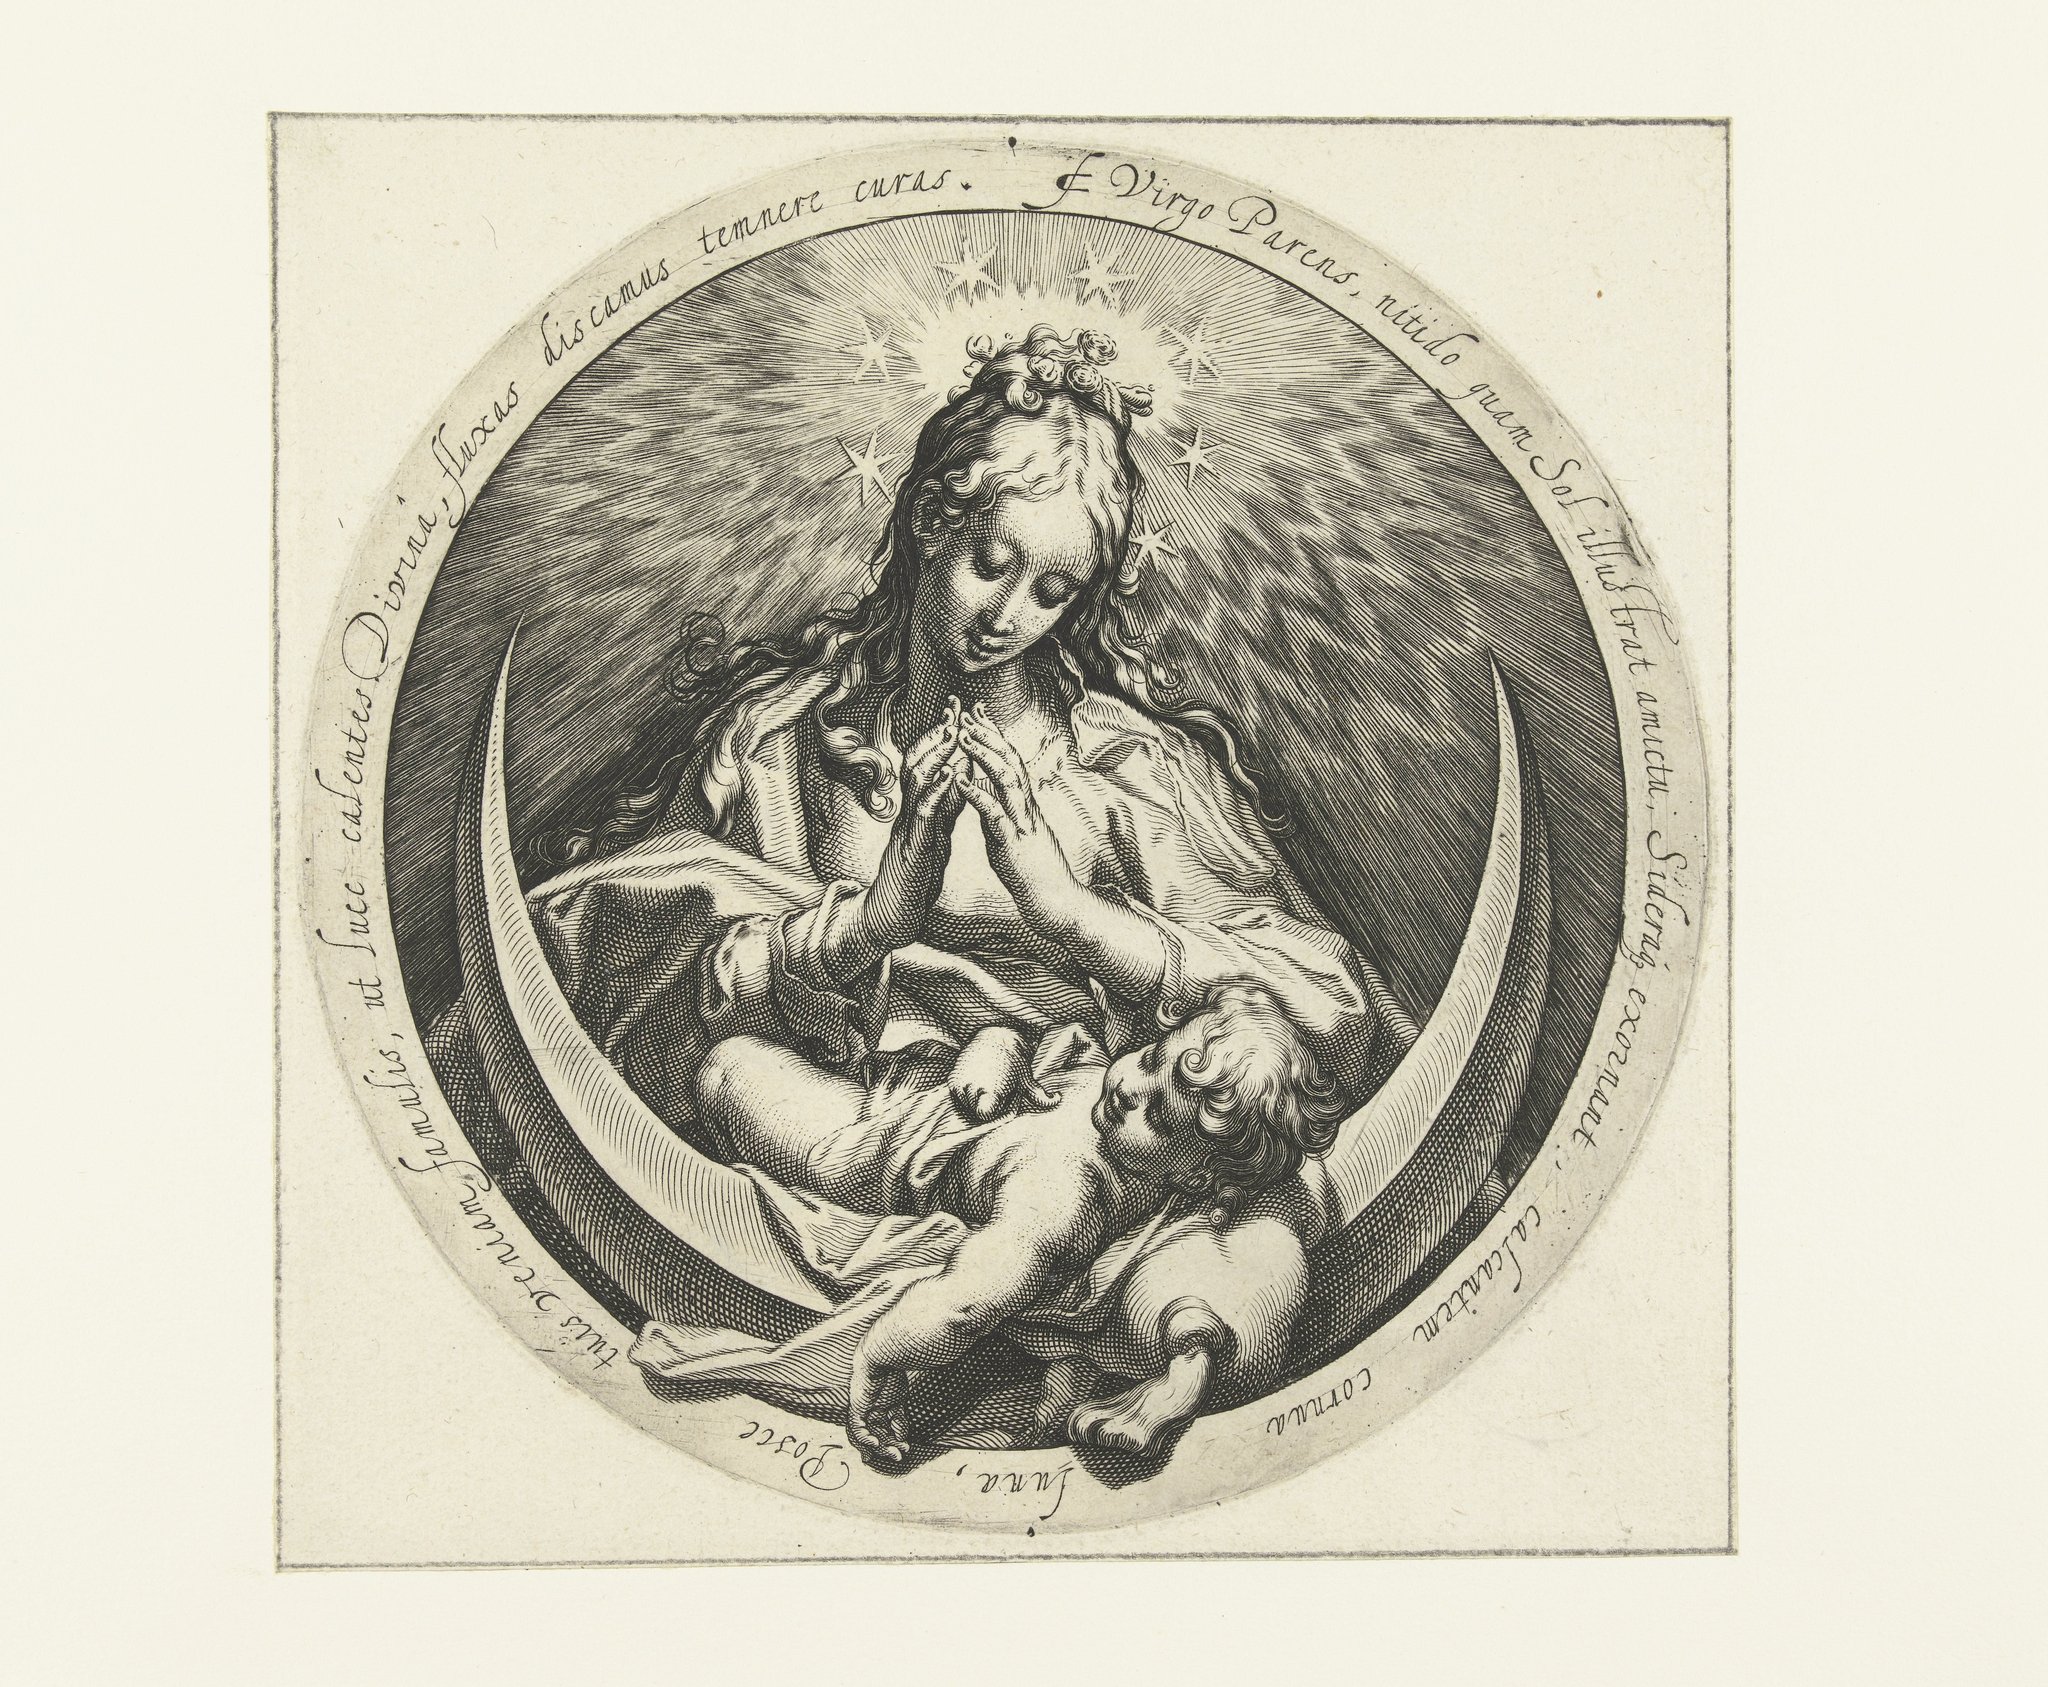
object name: print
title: Maria met Christuskind op maansikkel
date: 1593-1595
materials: paper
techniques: engraving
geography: netherlands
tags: madonna (i.e. mary with the christ-child) in the air, or on the clouds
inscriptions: collector's mark: Lugt 240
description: Ronde voorstelling van Maria, het hoofd omgeven door sterren, de handen in een biddend gebaar bijeen, neerkijkend op het Christuskind, dat op maansikkel voor haar ligt. Om de voorstelling een Latijns randschrift.